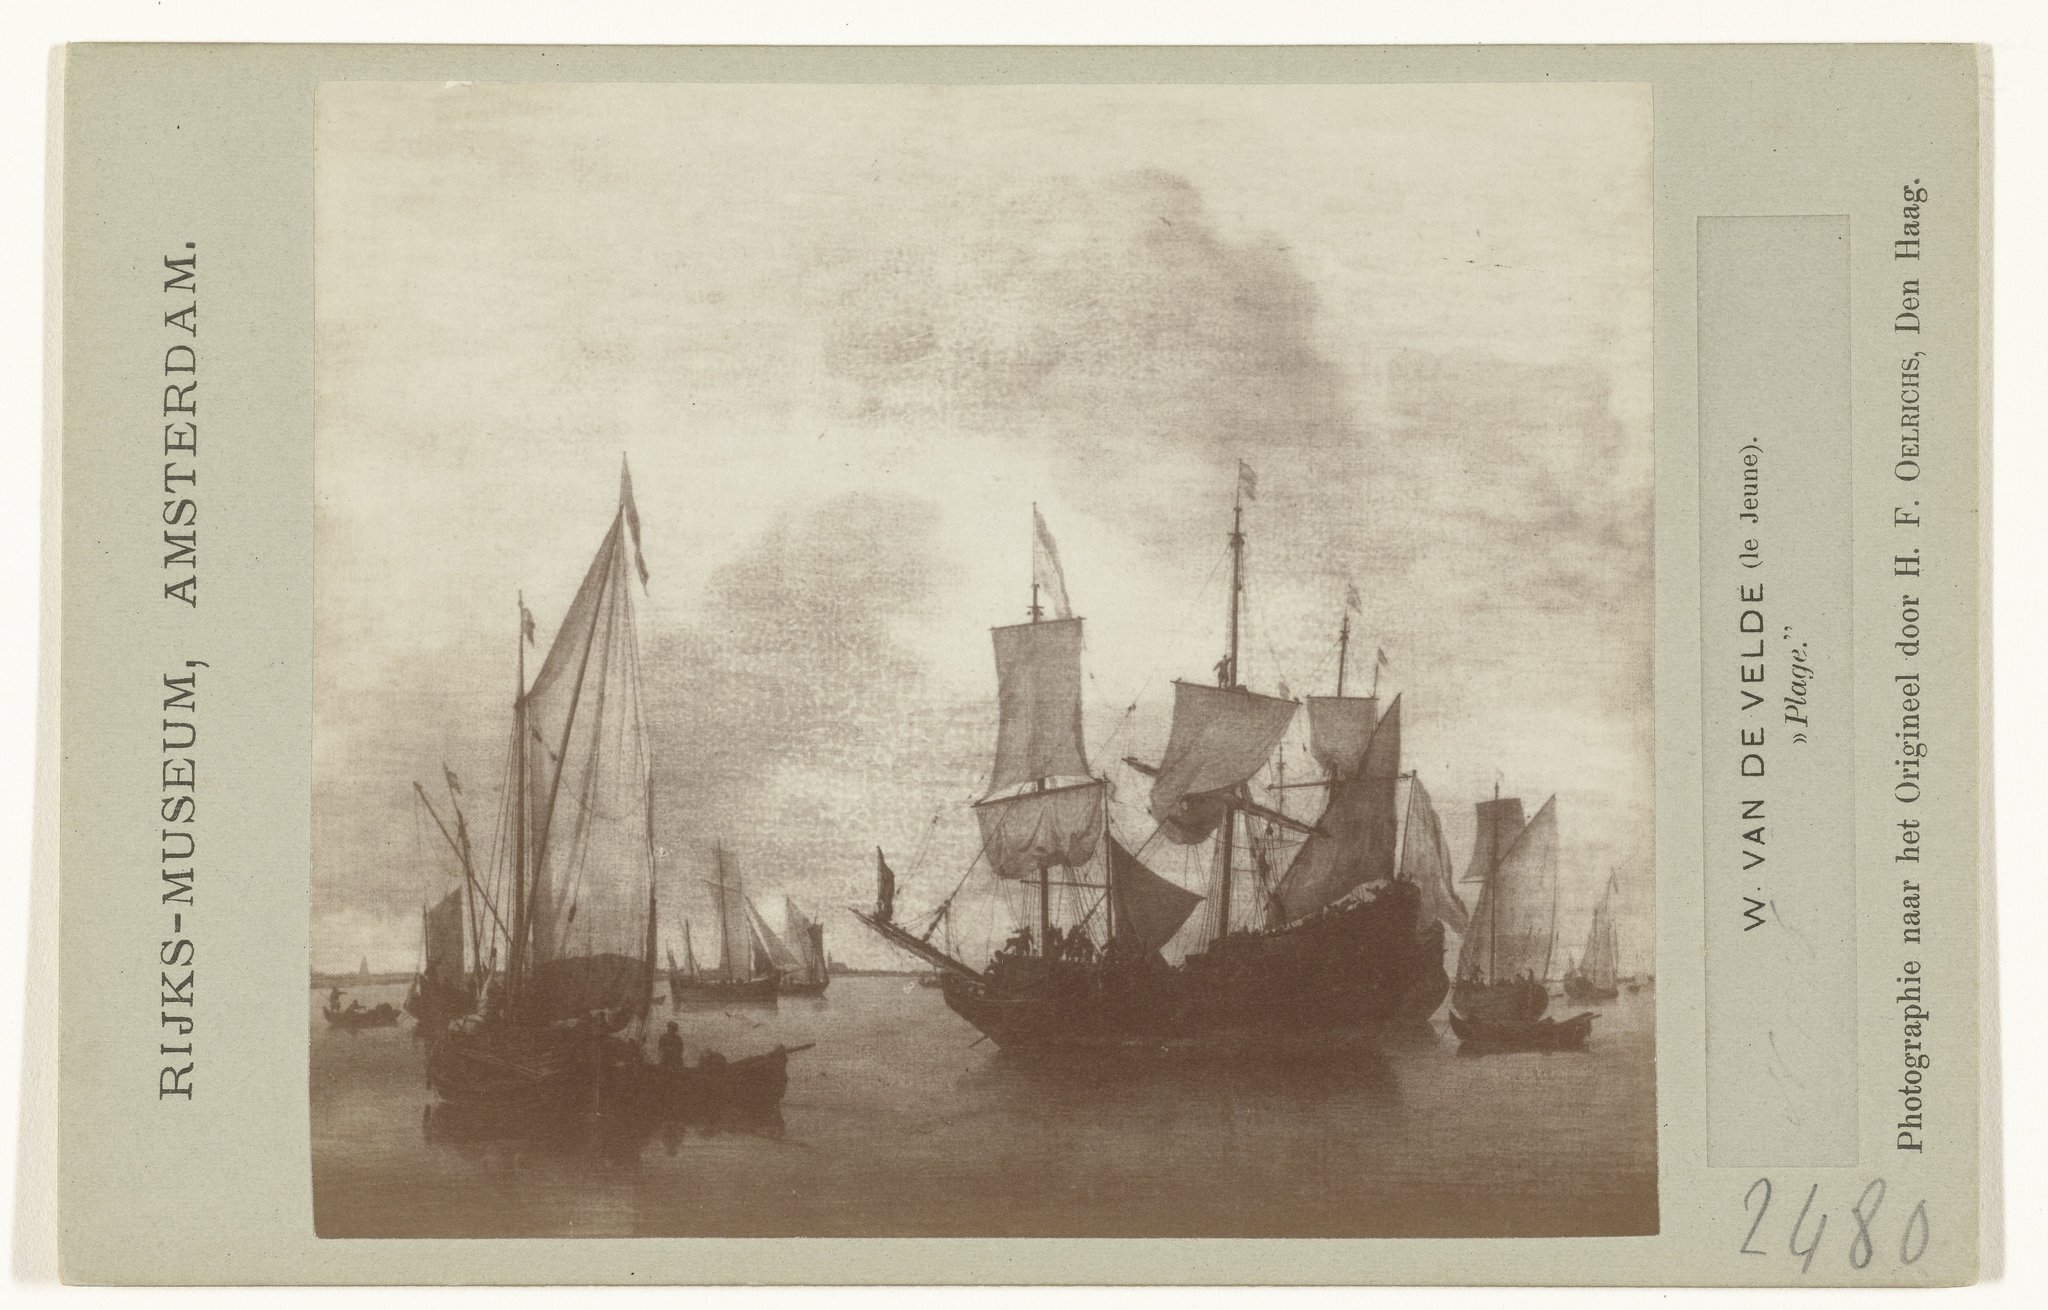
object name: photograph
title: Rijks-Museum, Amsterdam. W. van de Velde (le Jeune). "Plage."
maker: henri frederic oelrichs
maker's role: fotograaf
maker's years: 1850-1915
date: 1850-1880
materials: cardboard, paper, photographic support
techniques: albumen print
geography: the hague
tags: picture, painting